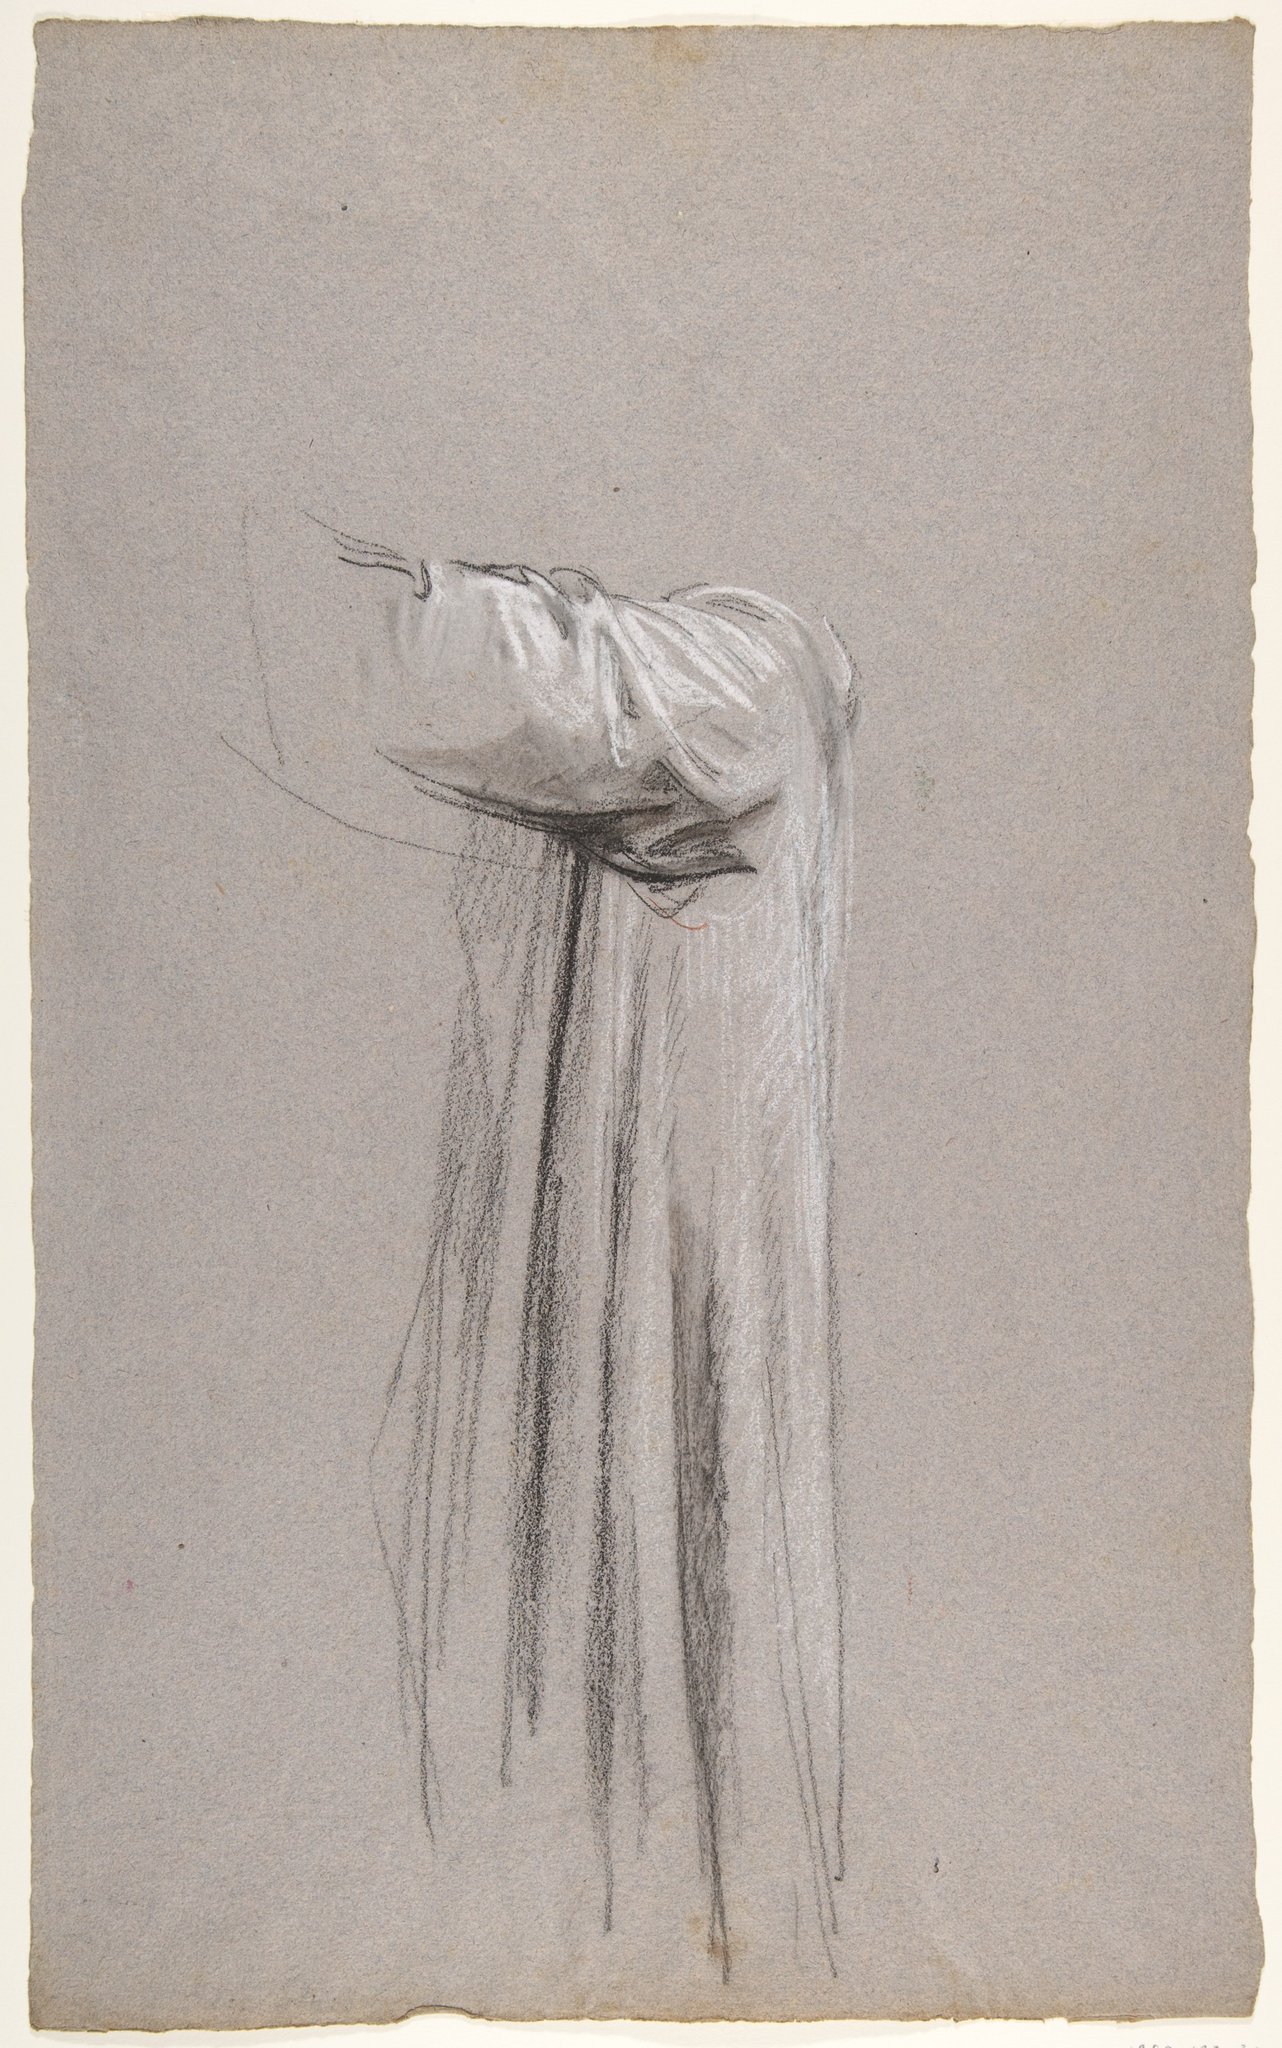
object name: drawing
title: Drapery Study for a Monk (lower register; study for wall paintings in the Chapel of Saint Remi, Sainte-Clotilde, Paris, 1858)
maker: isidore pils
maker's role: artist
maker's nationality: french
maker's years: 1813-1875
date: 1801-1900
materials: chalk, paper